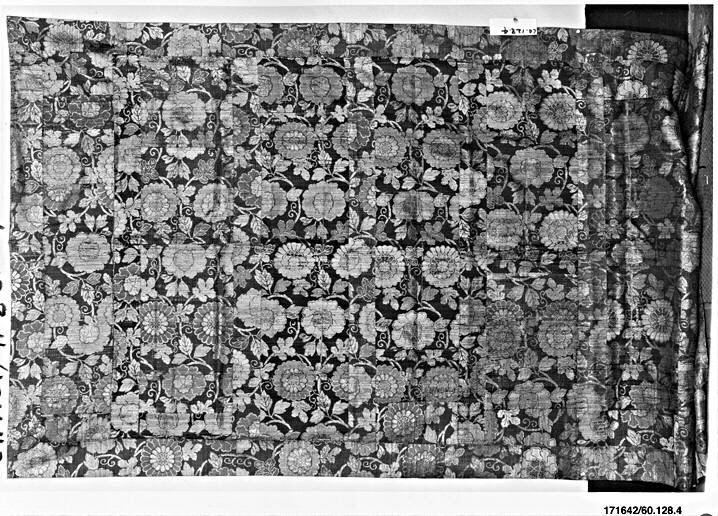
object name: robe, priest's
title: Priest's Robe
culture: japanese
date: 1601-1700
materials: metal thread, silk